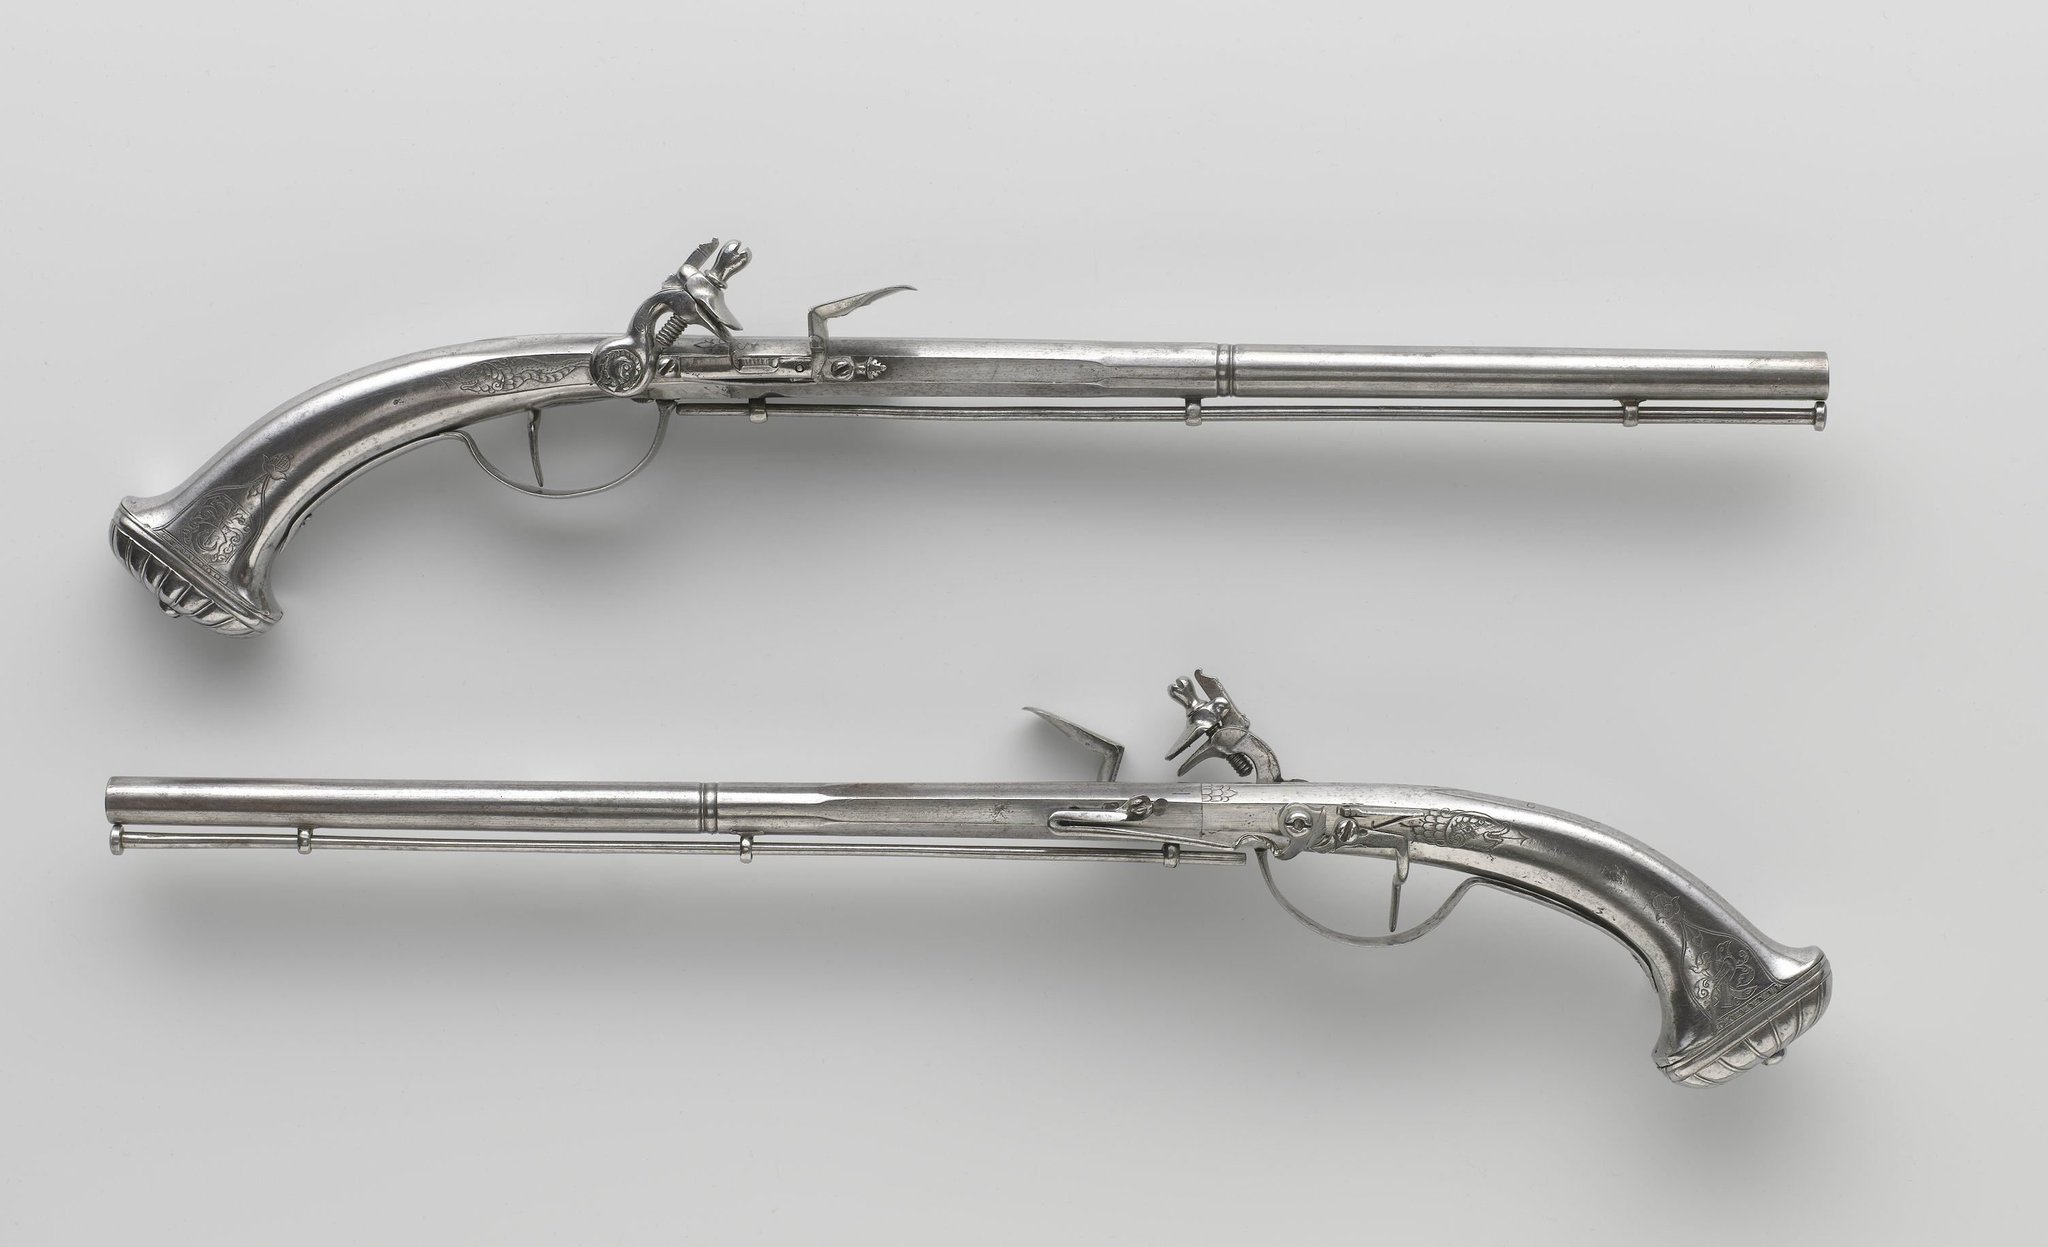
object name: flintlock pistol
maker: jan cloeter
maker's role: geweermaker, pistoolmaker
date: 1655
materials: iron, steel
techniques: printing, engraving, soldering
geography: grevenbroich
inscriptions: inscription: ‘Imiecz tem u poblara ij kula folgiuie’, mark: ‘K S; I C’, : ‘I D’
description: In the late 17th century pistols made entirely of iron were produced in the border region of the Netherlands and Germany (Westphalia). These were often exclusive gifts. This pair was probably owned by a Polish officer.